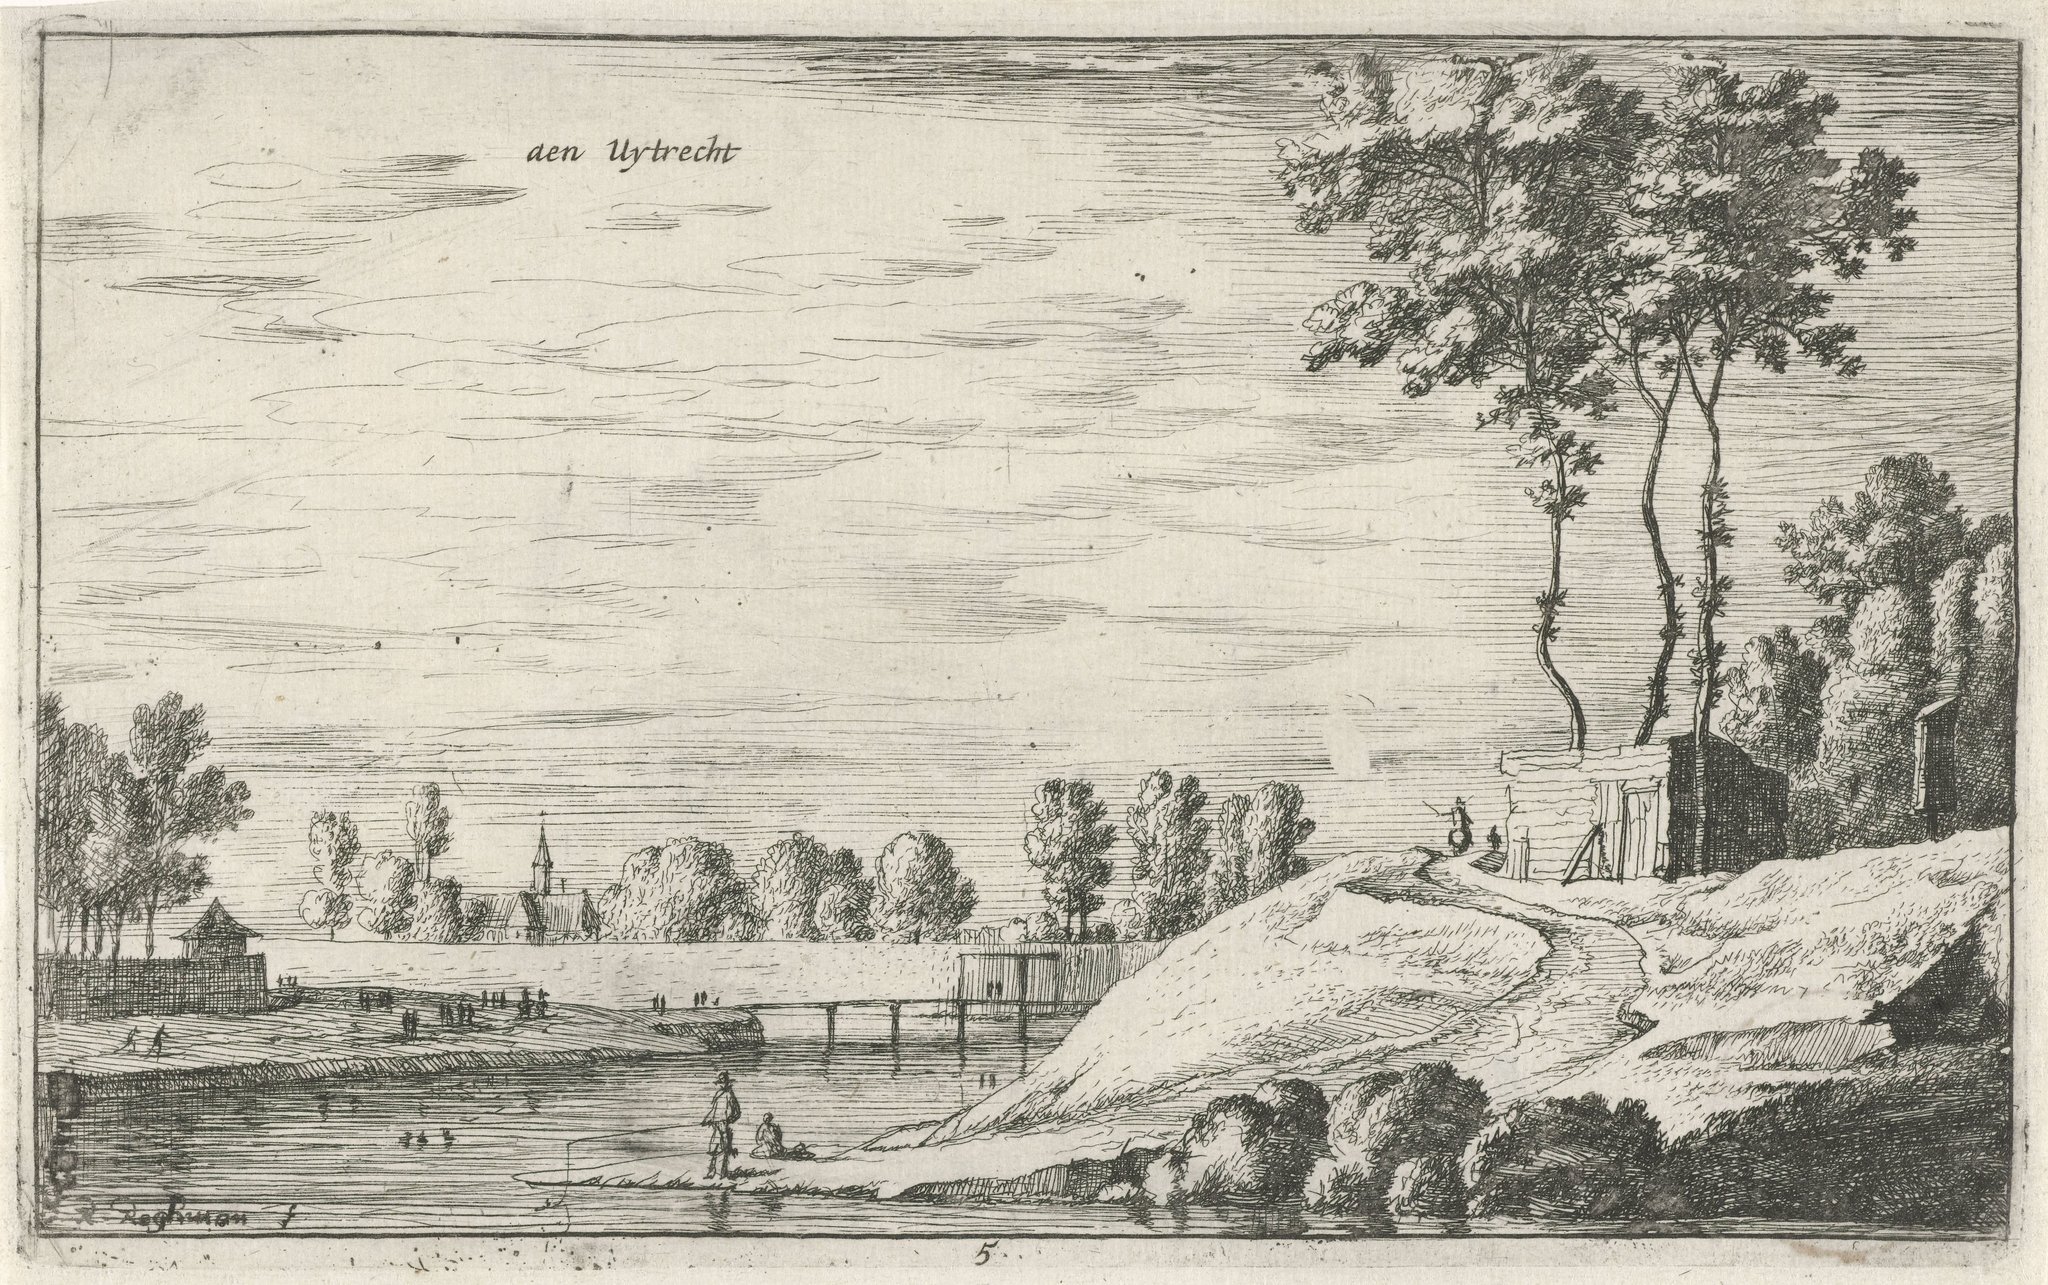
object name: print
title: Riviergezicht bij Utrecht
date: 1637-1677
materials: paper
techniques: etching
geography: amsterdam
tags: river, dikes, levee, bridge, fisherman, utrecht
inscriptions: collector's mark: Lugt 240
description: Gezicht op een rivier (mogelijk de Lek) in de omgeving van Utrecht. Aan de waterkant bevinden zich twee vissers en op de dijk rijdt een ruiter. Op de achtergrond een ophaalbrug en de contouren van een kerk. Genummerd onderaan in de marge: 5.